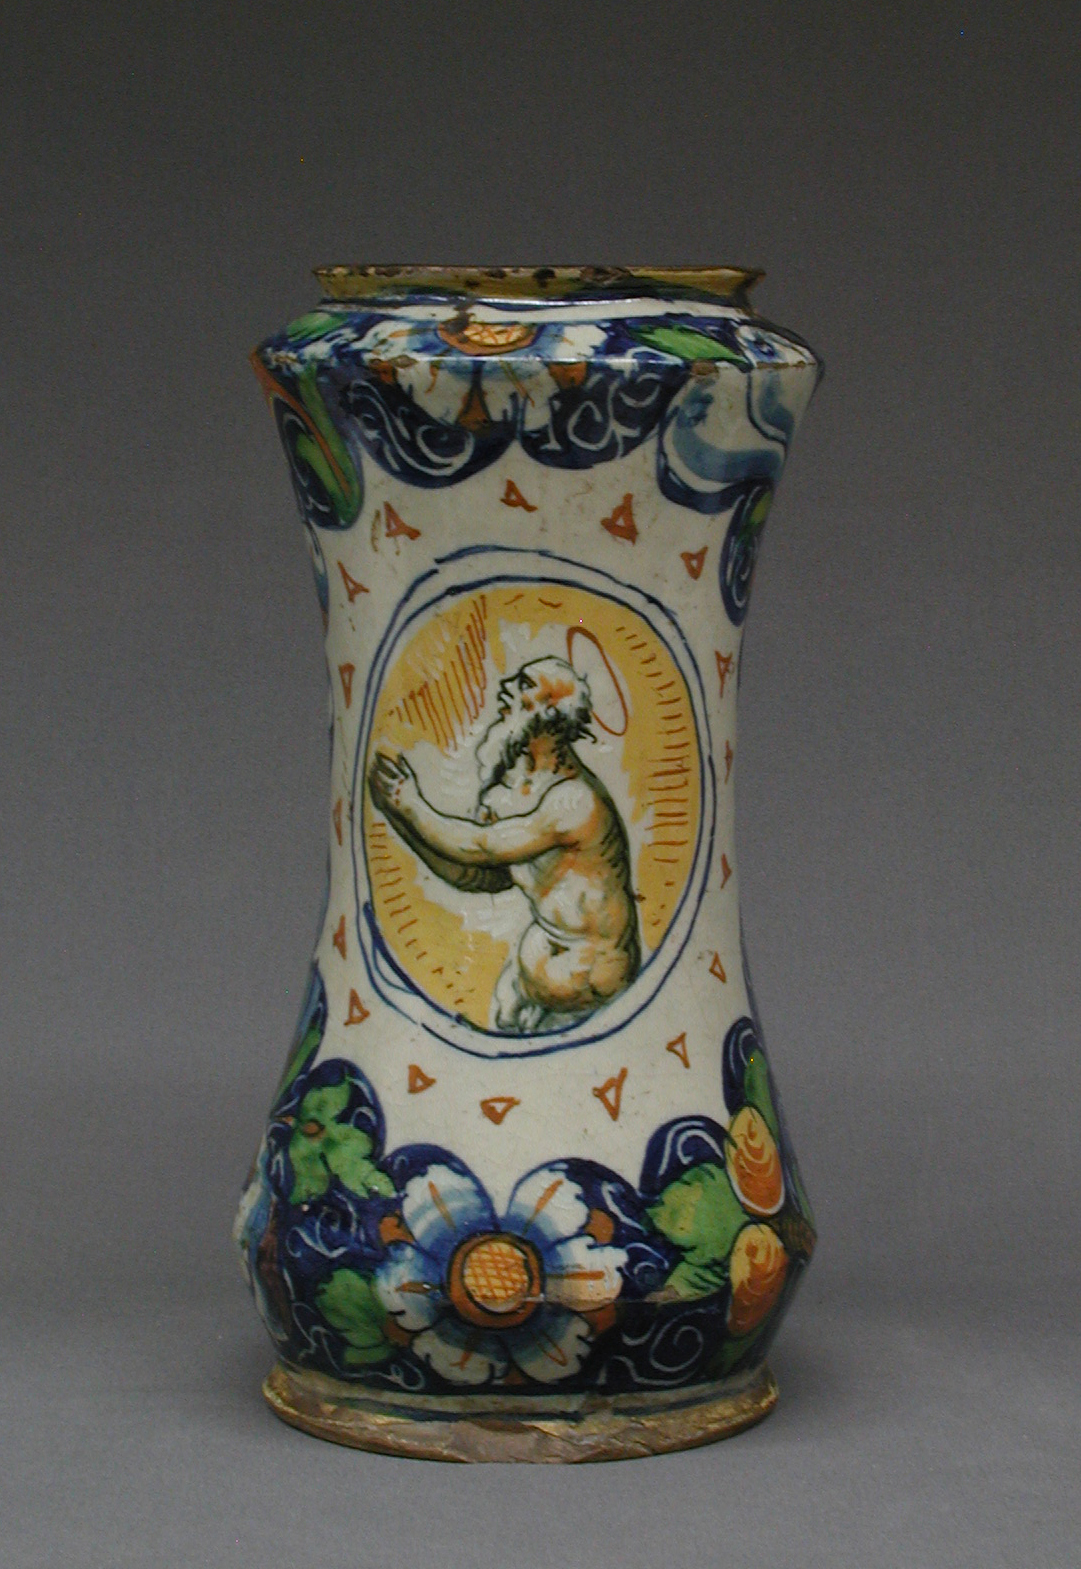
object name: albarello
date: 1551-1600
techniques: maiolica, glazing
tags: men,flowers